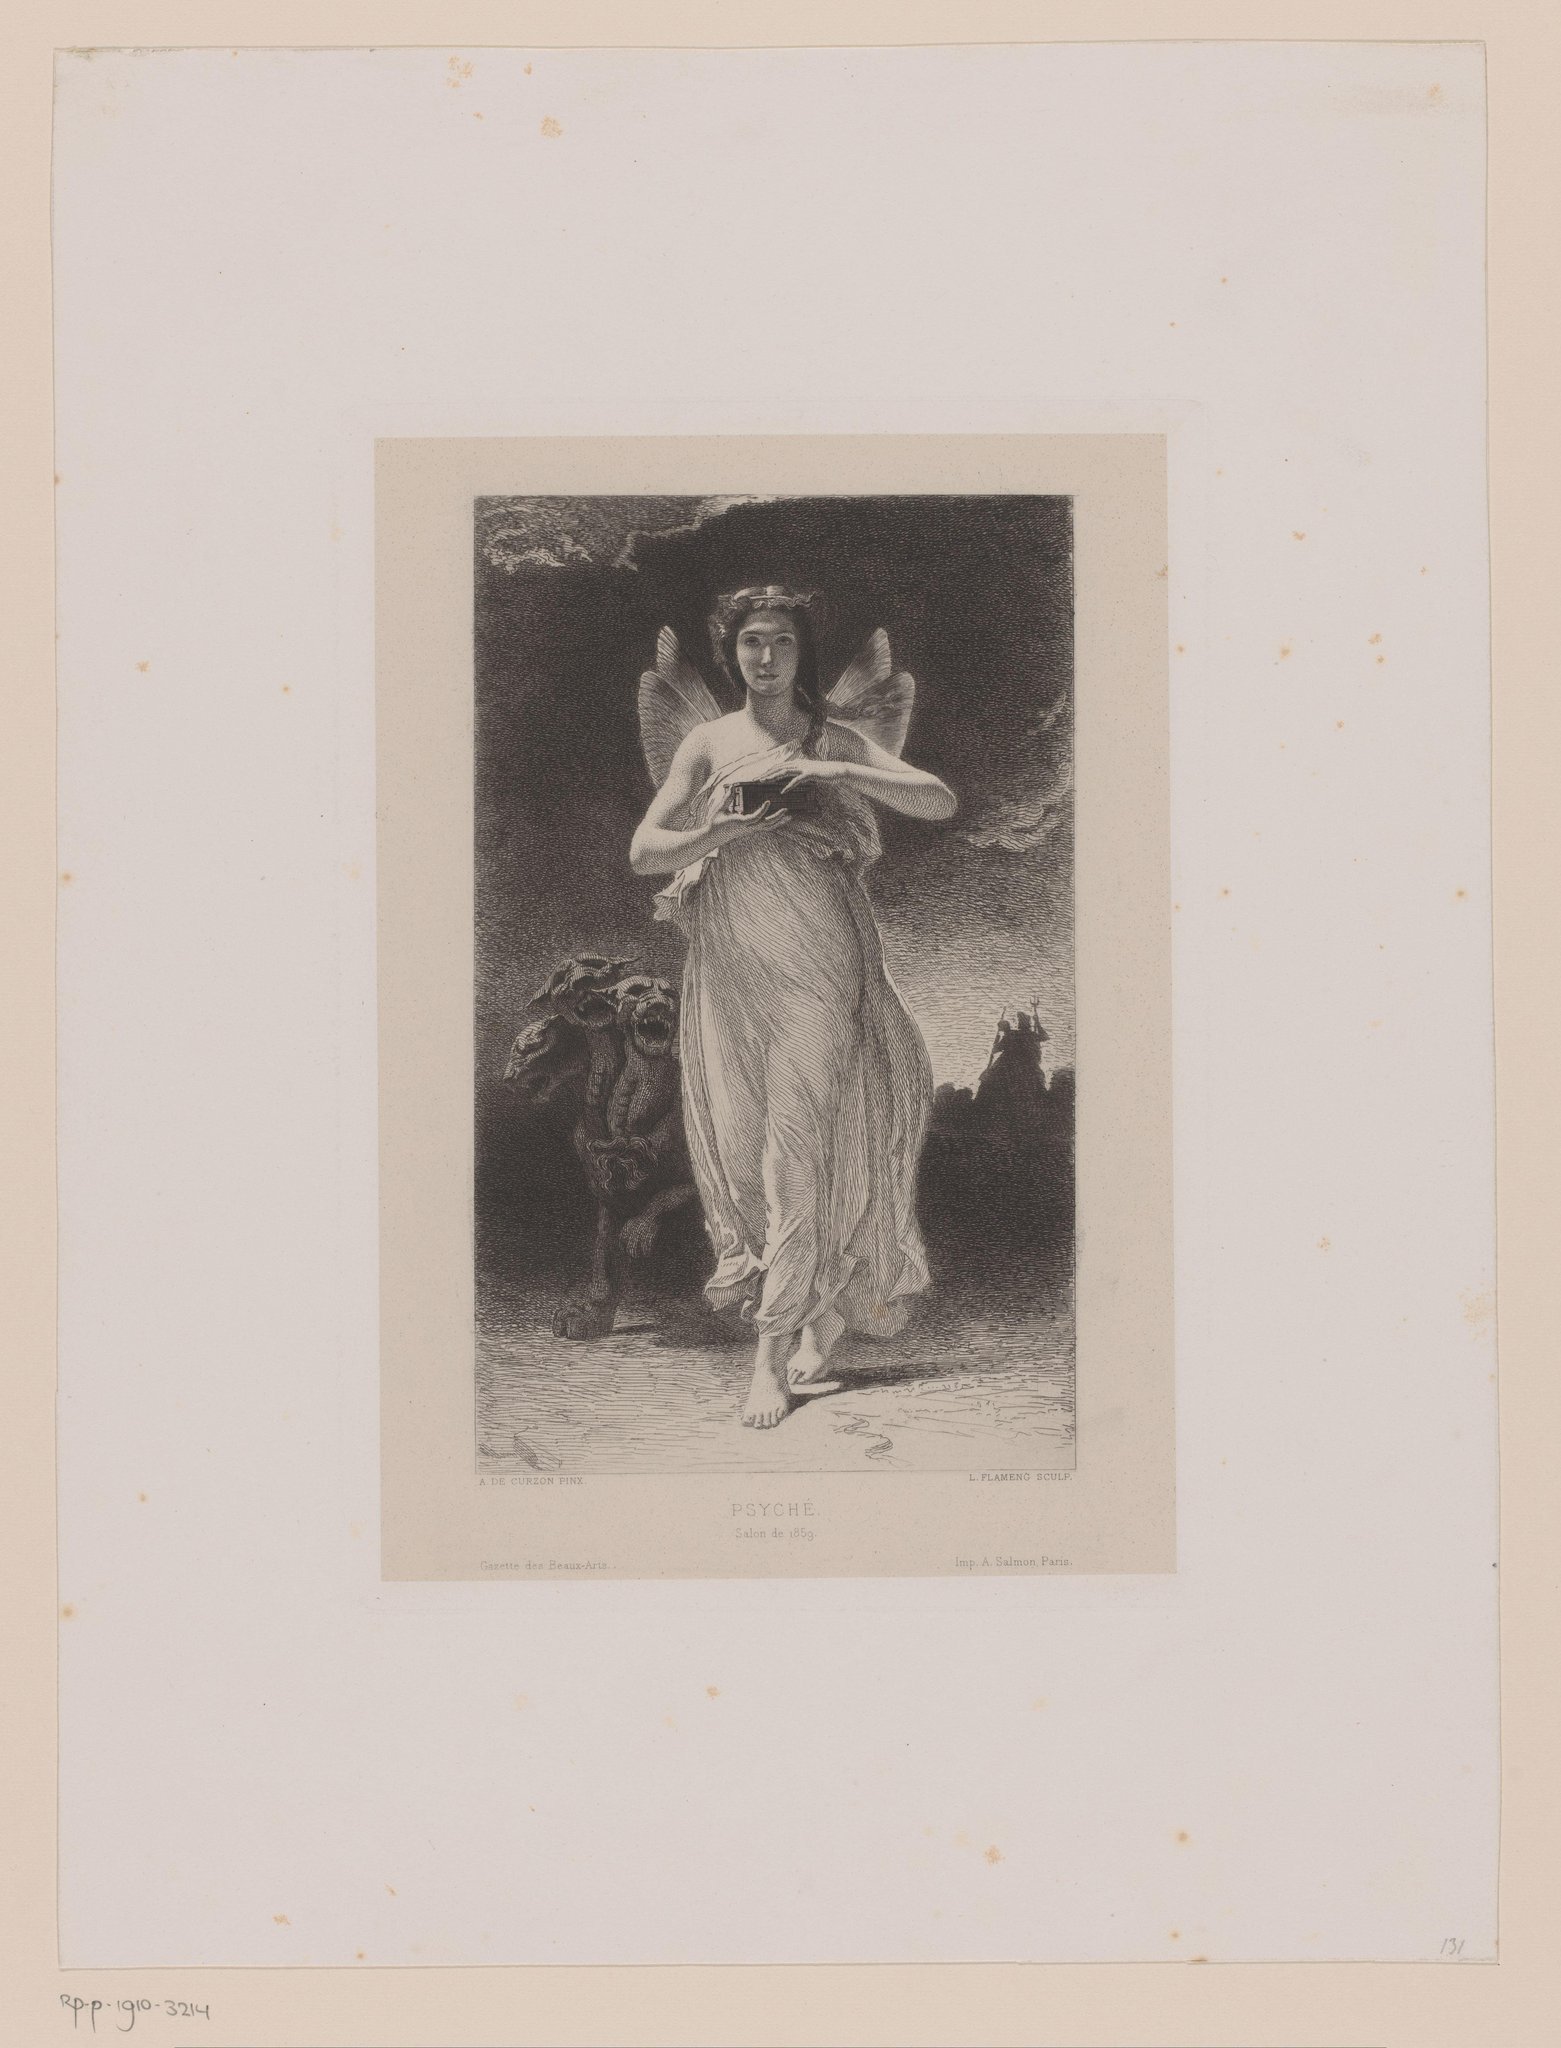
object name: print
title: Psyche met aan haar voeten Cerberus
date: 1859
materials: paper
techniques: etching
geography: paris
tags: psyche is sent into the underworld to fetch proserpina's casket of beauty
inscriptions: collector's mark: Lugt 2228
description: Prent uit: Gazette des beaux-arts (1859), nr. 2, p. 202.